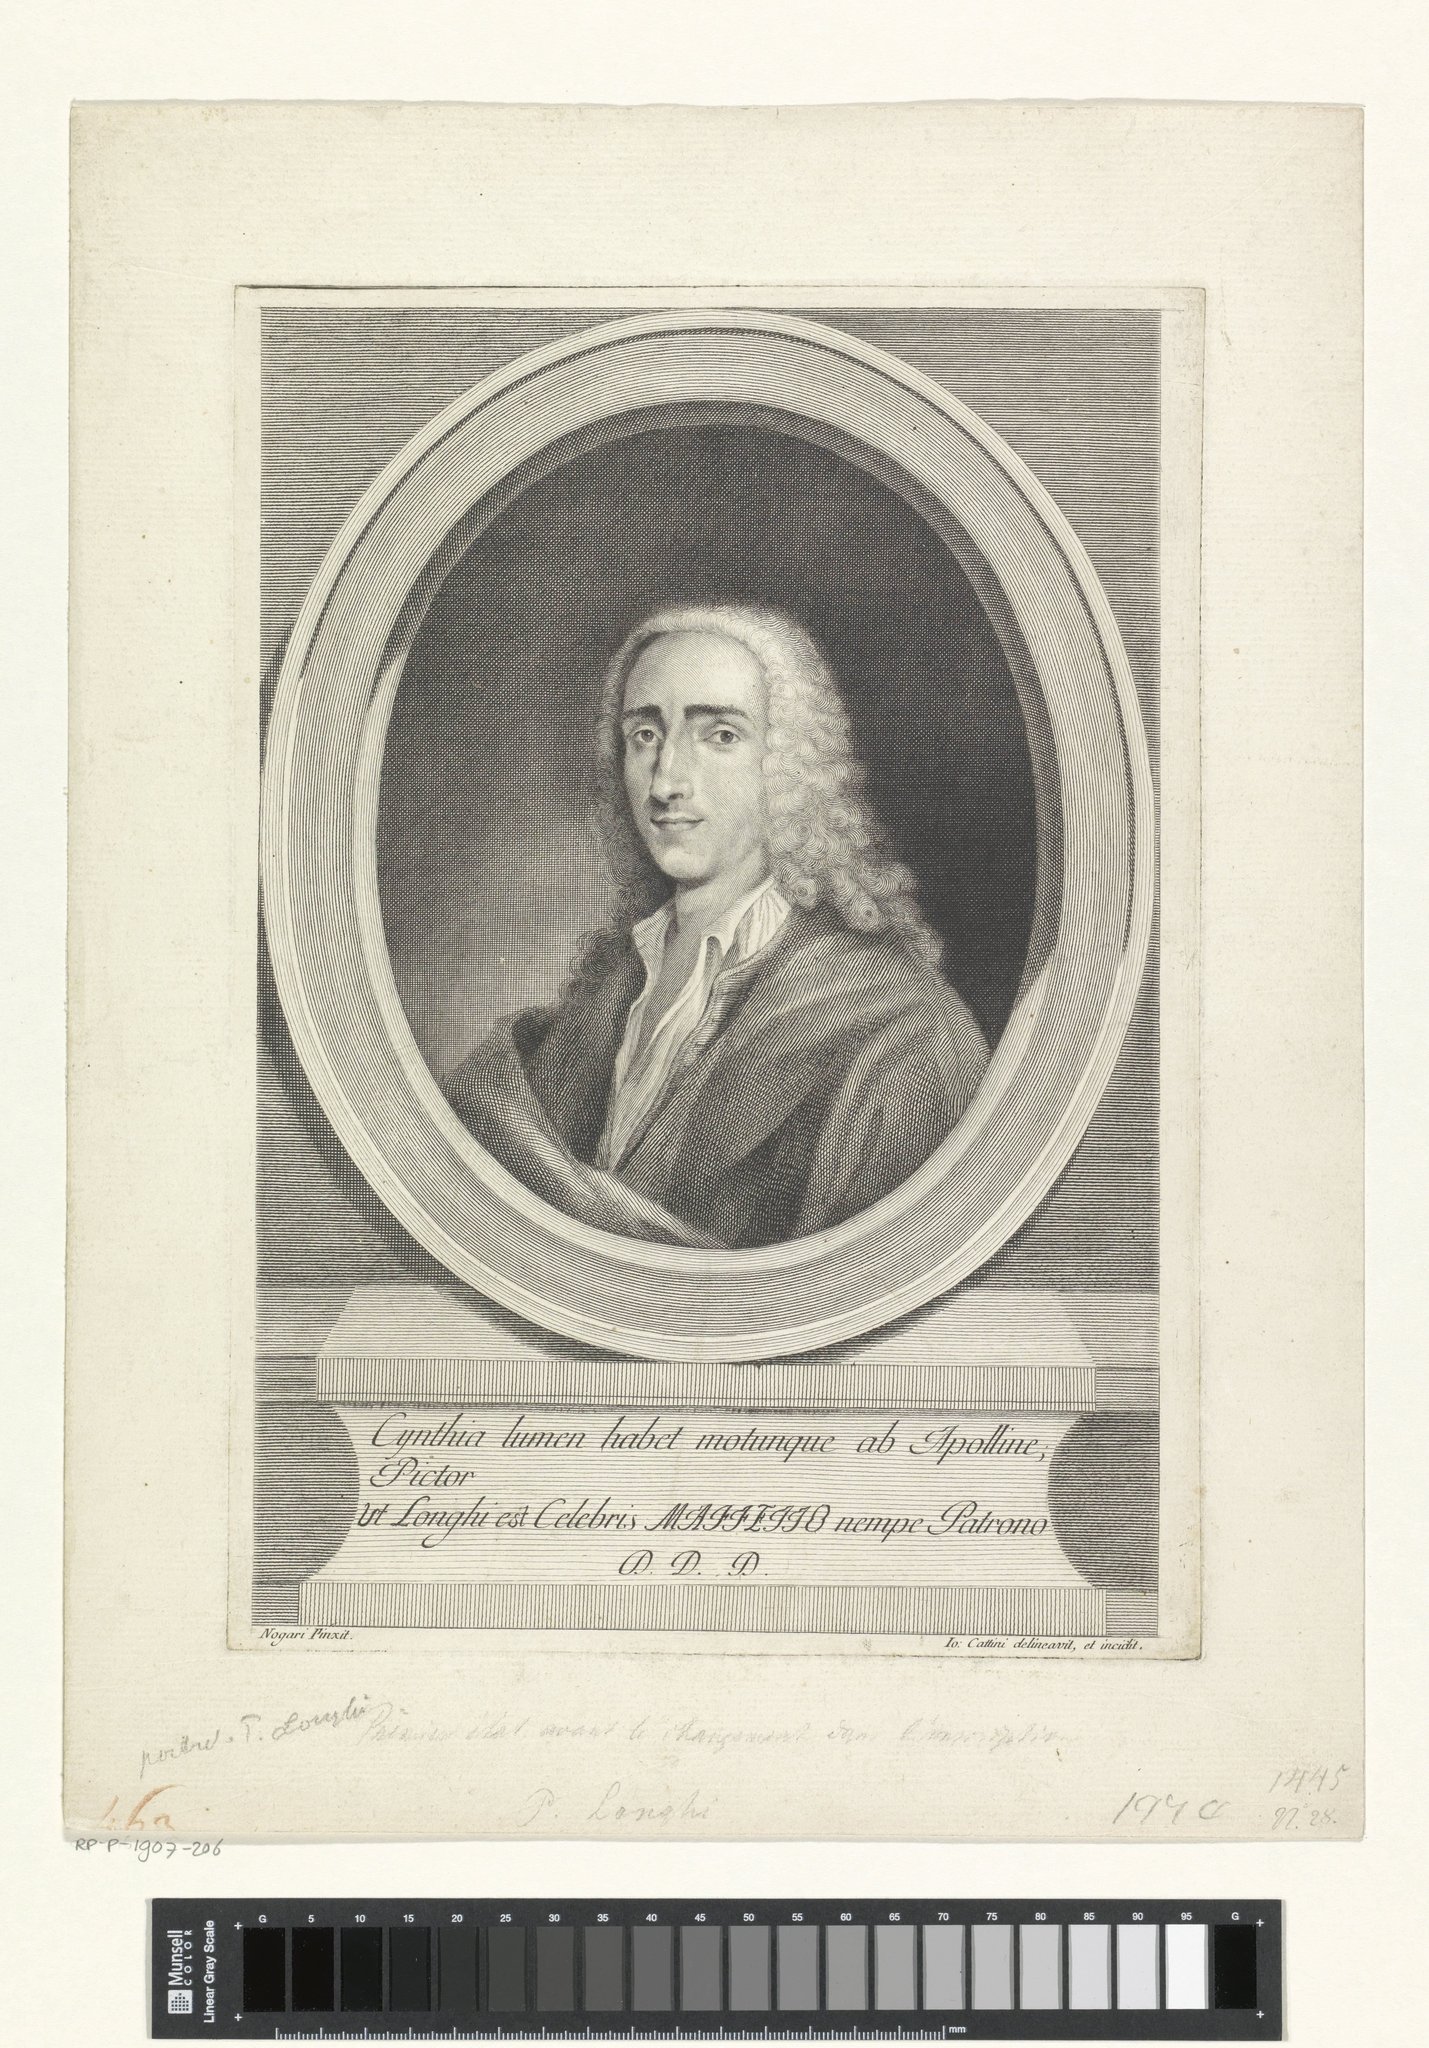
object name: print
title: Portret van schilder Pietro Longhi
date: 1735-1800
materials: paper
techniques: engraving, etching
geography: italy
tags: venice, painter, pietro longhi, historical persons, portrait, self-portrait of artist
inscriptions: collector's mark: Lugt 2228